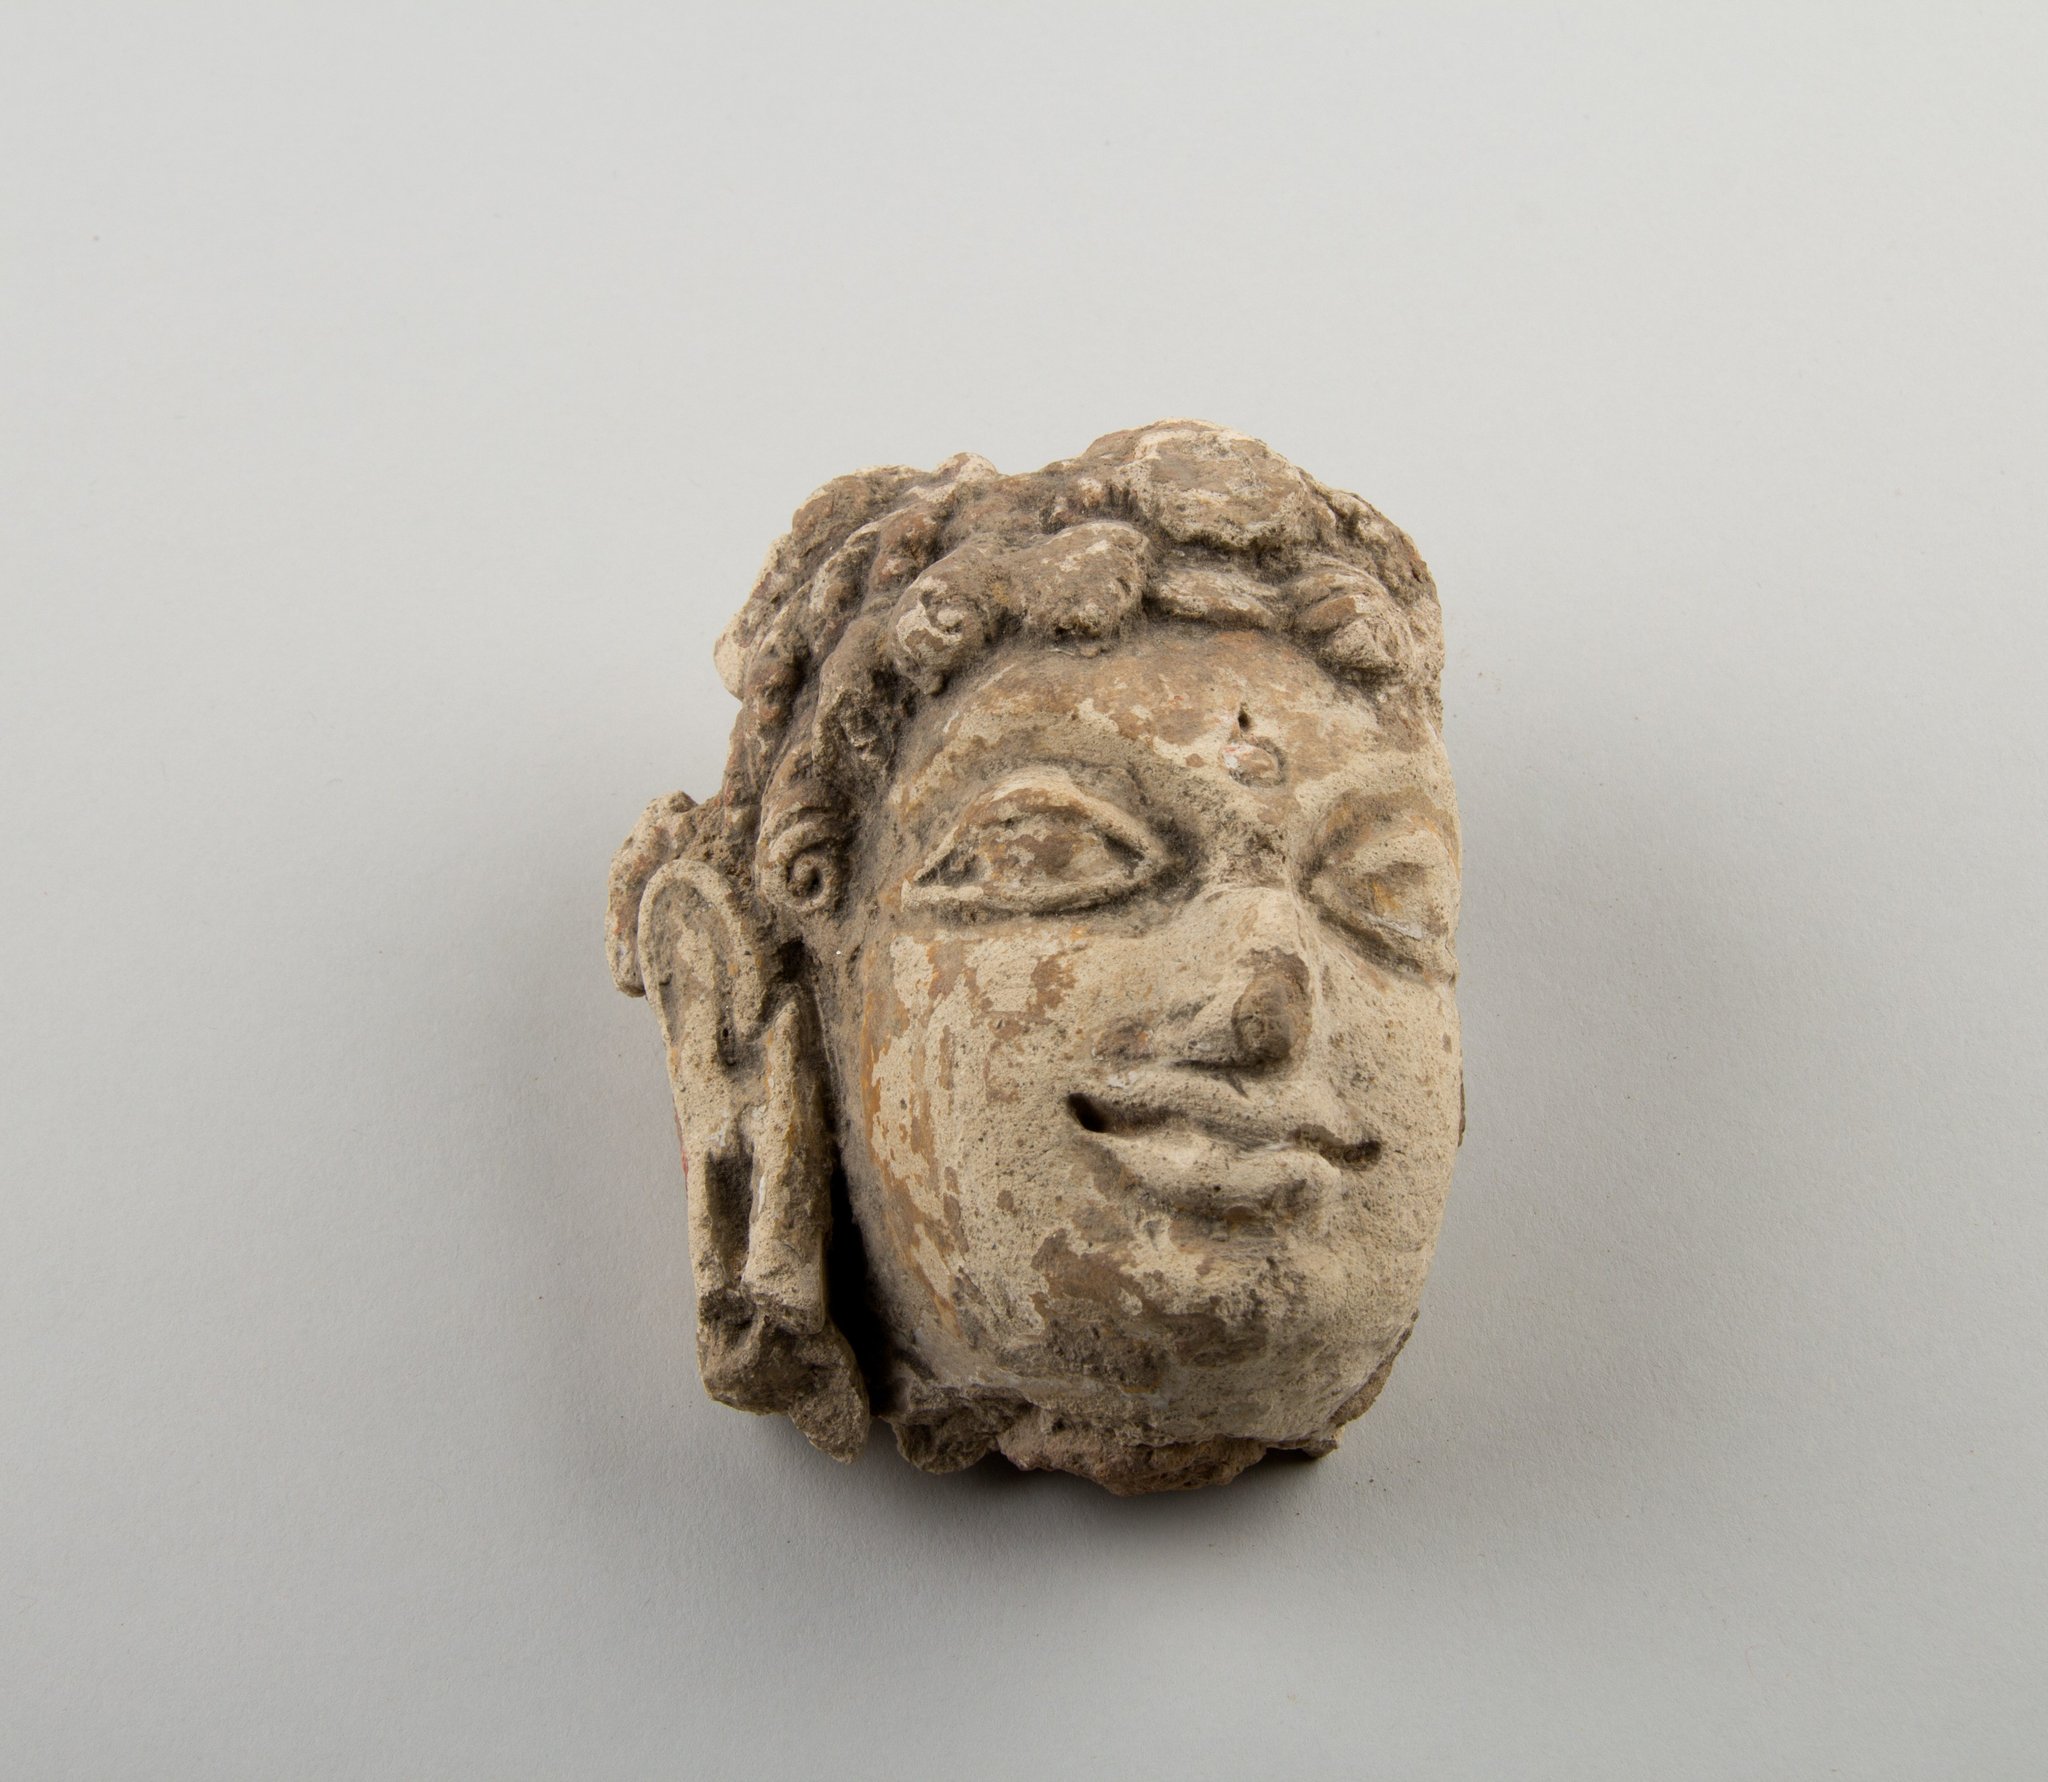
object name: head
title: Head of a Bodhisattva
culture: indian, nalanda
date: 601-800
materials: clay, plaster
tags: heads,buddhism,bodhisattvas